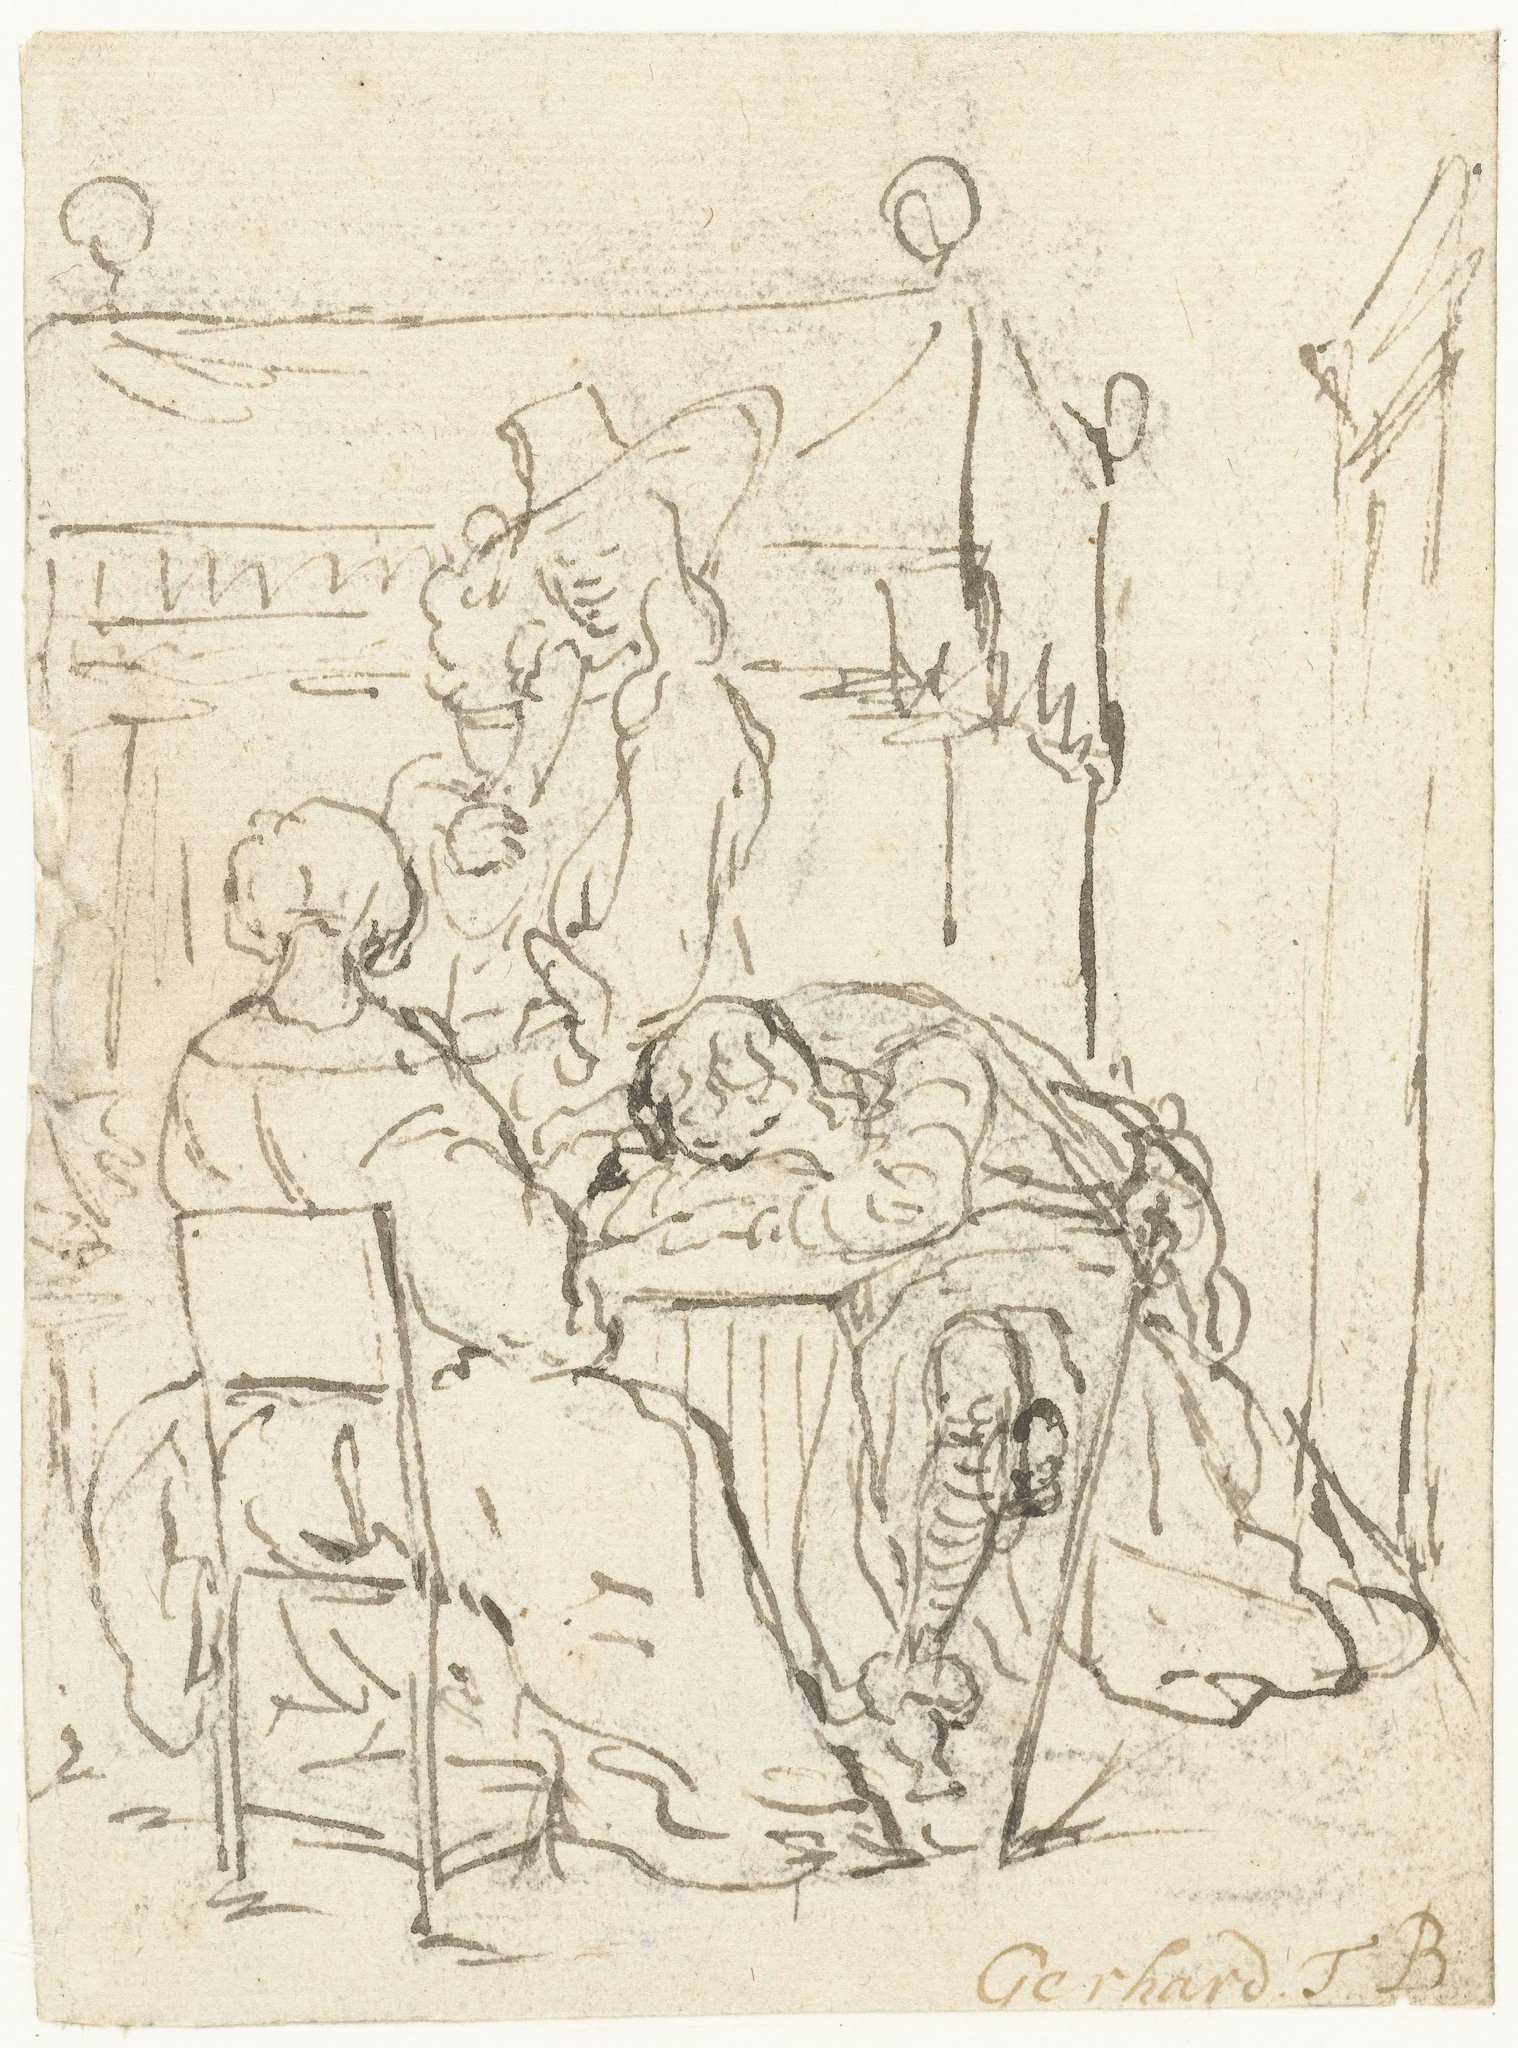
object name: drawing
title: Drinktafereel met een zittende dame, een slapende soldaat en een staande heer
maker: gerard ter borch (ii)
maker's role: draughtsman, painter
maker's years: 1617-1681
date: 1655-1661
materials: chalk, ink, paper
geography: deventer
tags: sleeping; unconsciousness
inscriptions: signature: ‘Gerhard T.B.’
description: De soldaat in deze tekening is identiek aan de soldaat in "De drinkende dame en slapende soldaat", gedateerd ca. 1658 (Gudlaugsson no. 146); het hele blad is een variatie op schilderijen met hetzelfde thema en van dezelfde periode, ca. 1656-1660 (Gudlaugsson, nos. 122, 146 en 166).